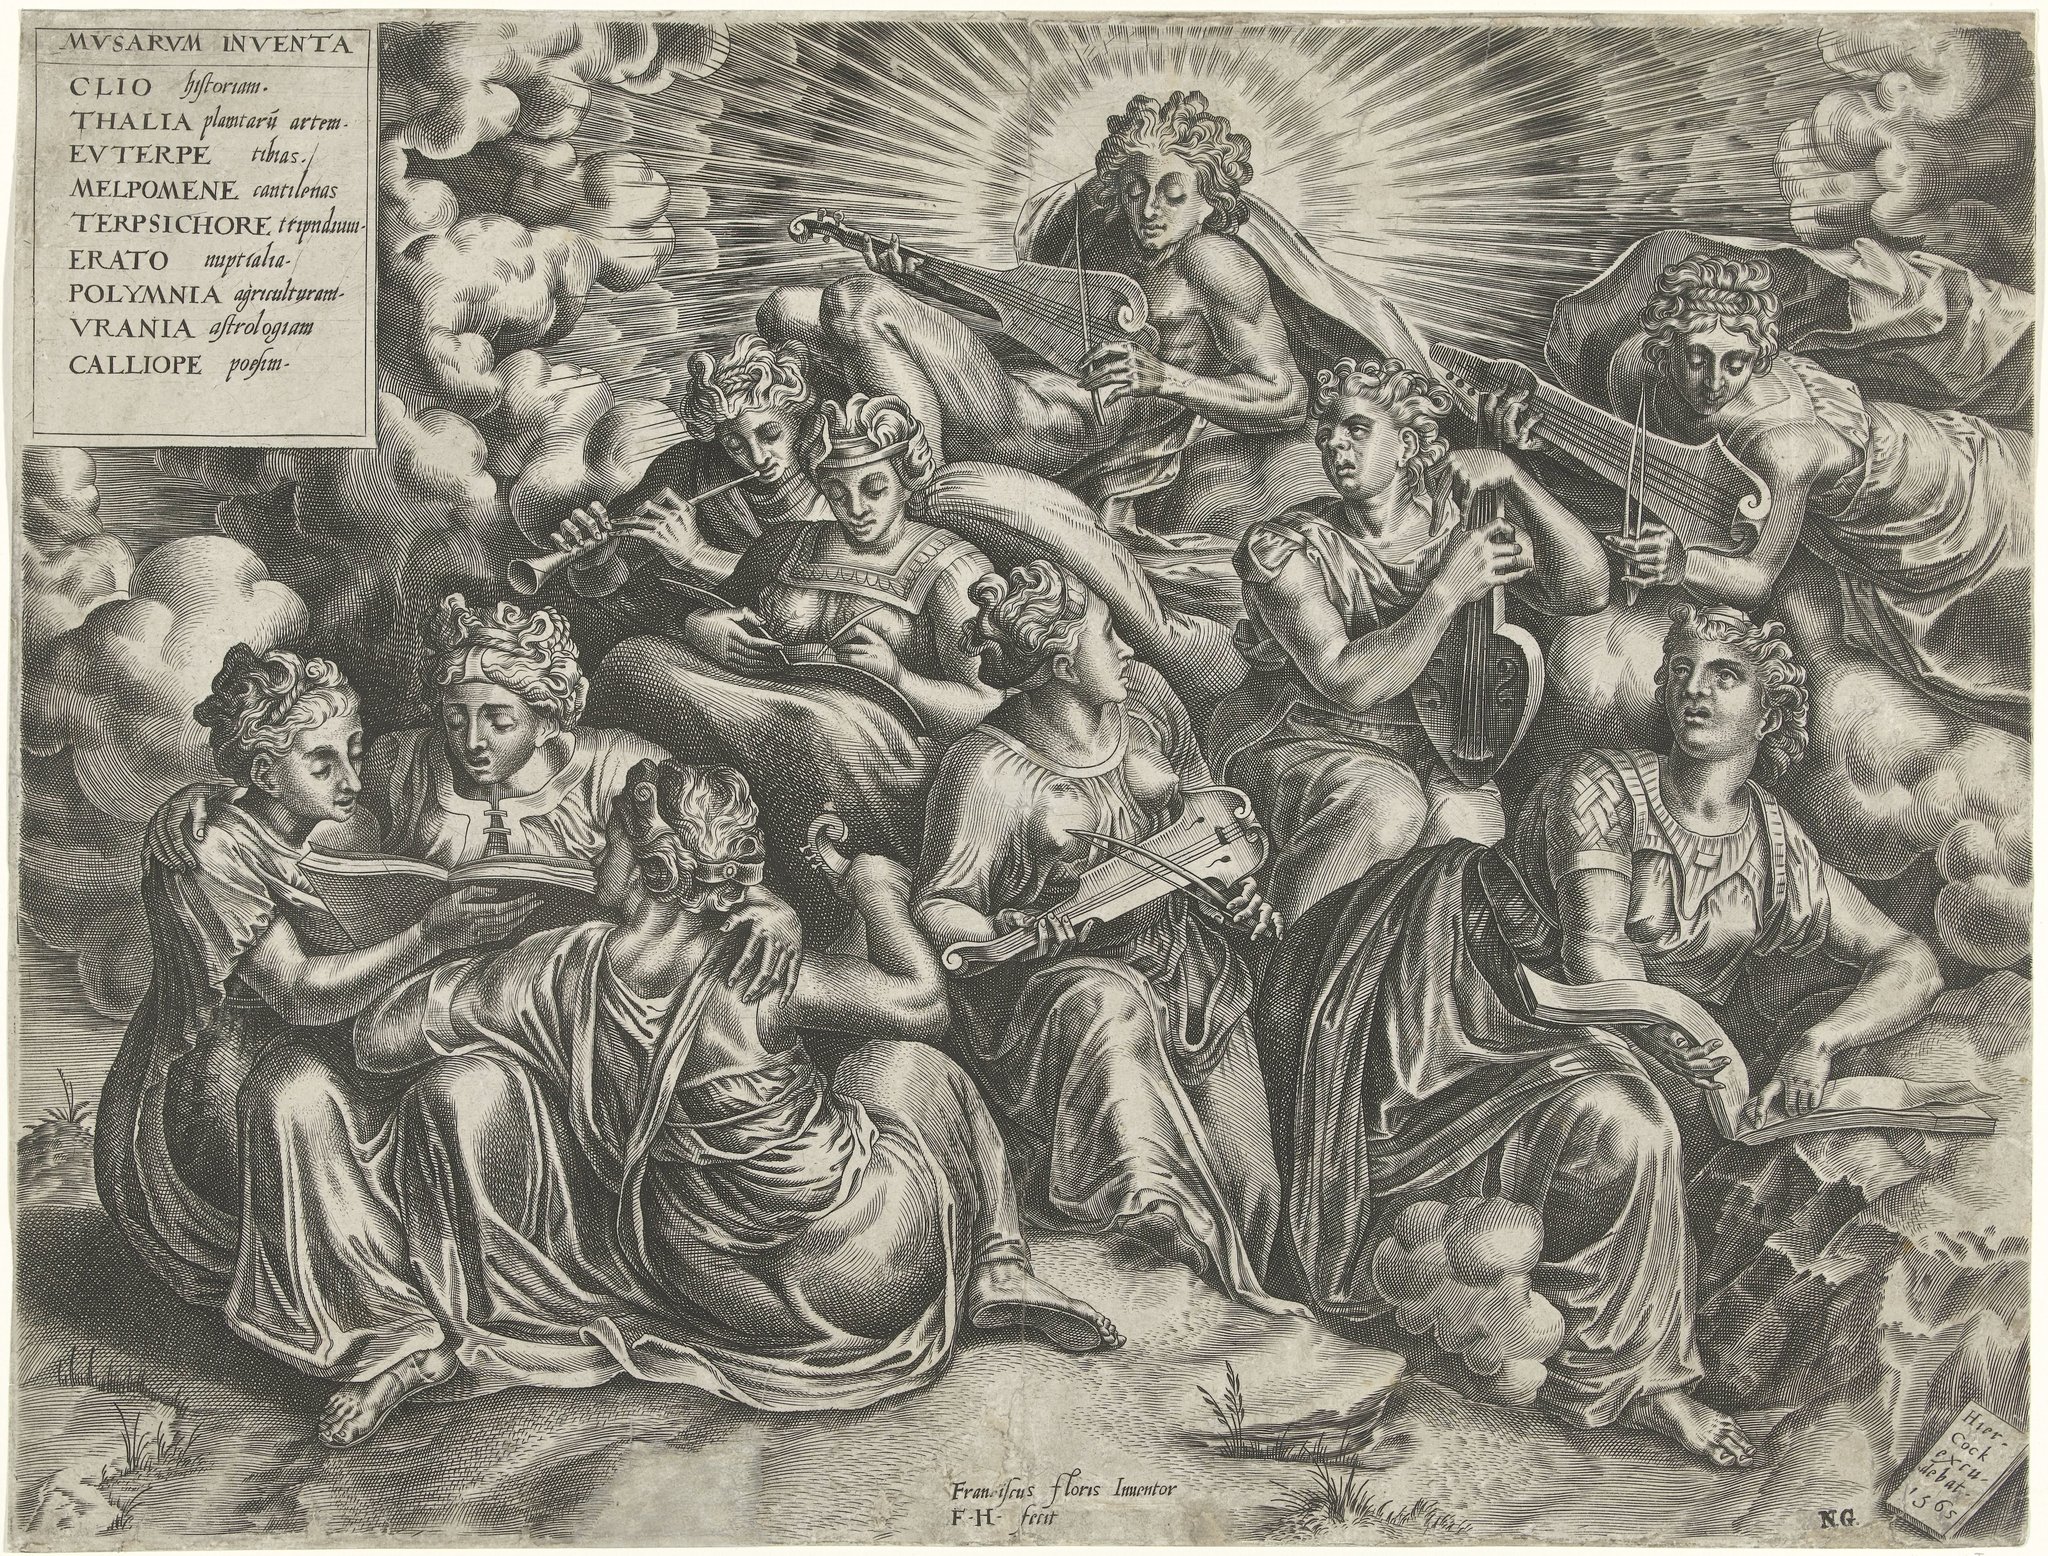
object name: print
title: Apollo en de Muzen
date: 1565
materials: paper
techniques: engraving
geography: antwerp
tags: apollo and the muses, apollo musagetes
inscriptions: inscription: Lugt 1967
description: Apollo in gezelschap van de negen Muzen op de berg Parnassus. Apollo troont bovenaan en bespeelt de lier. Onder Apollo de Muzen met een boek of muziekinstrument. In de linker bovenhoek de namen van de Muzen en de bijbehorende kunsten in Latijn.